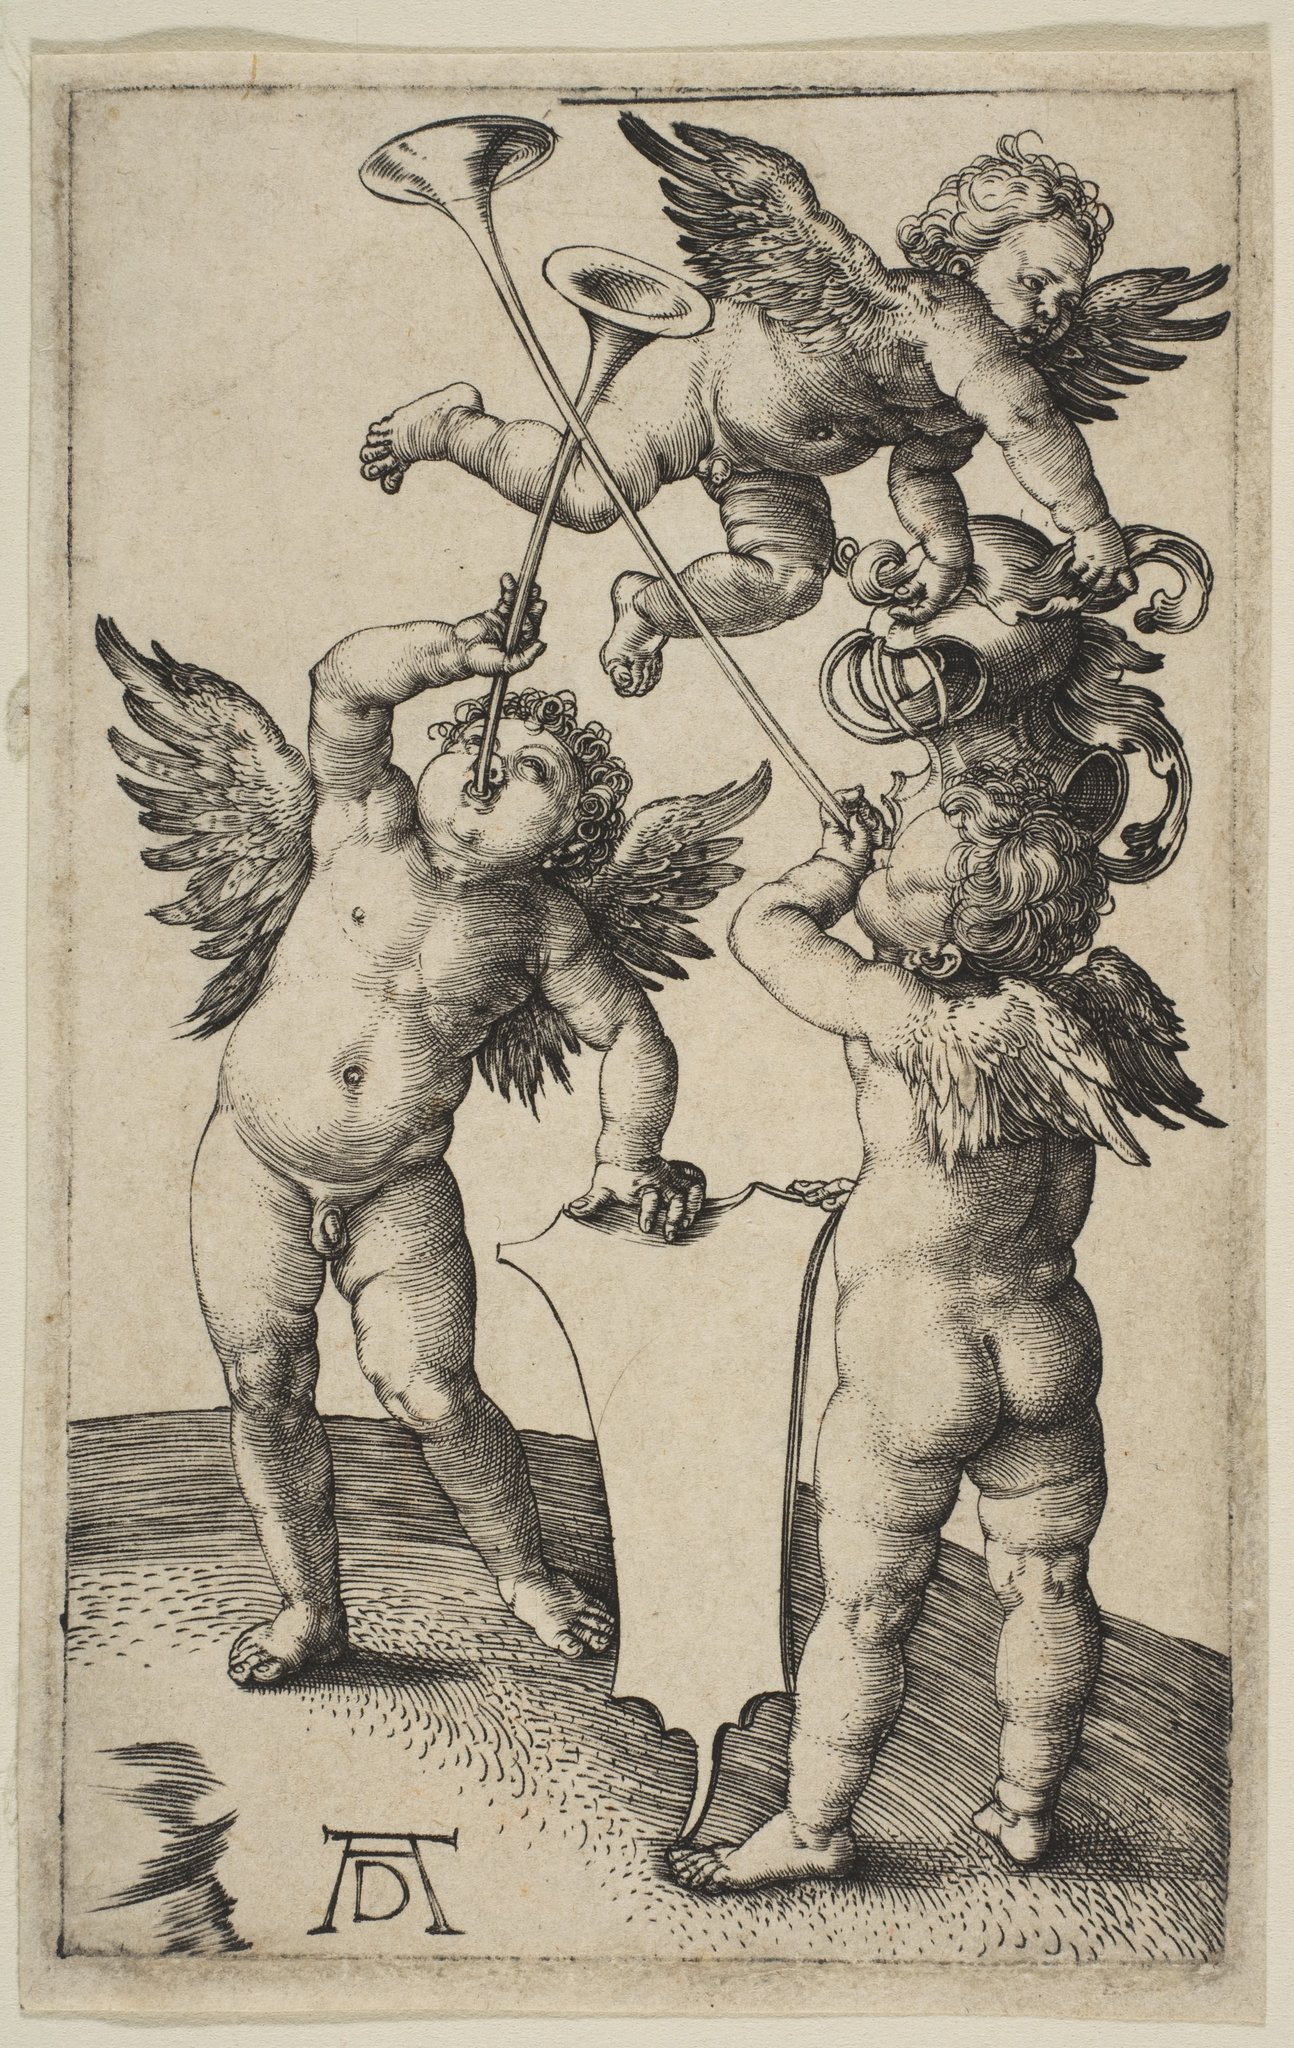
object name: print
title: Three Putti with Trumpets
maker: albrecht dürer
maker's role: artist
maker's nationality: german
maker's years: 1471-1528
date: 1500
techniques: engraving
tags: trumpets,putti